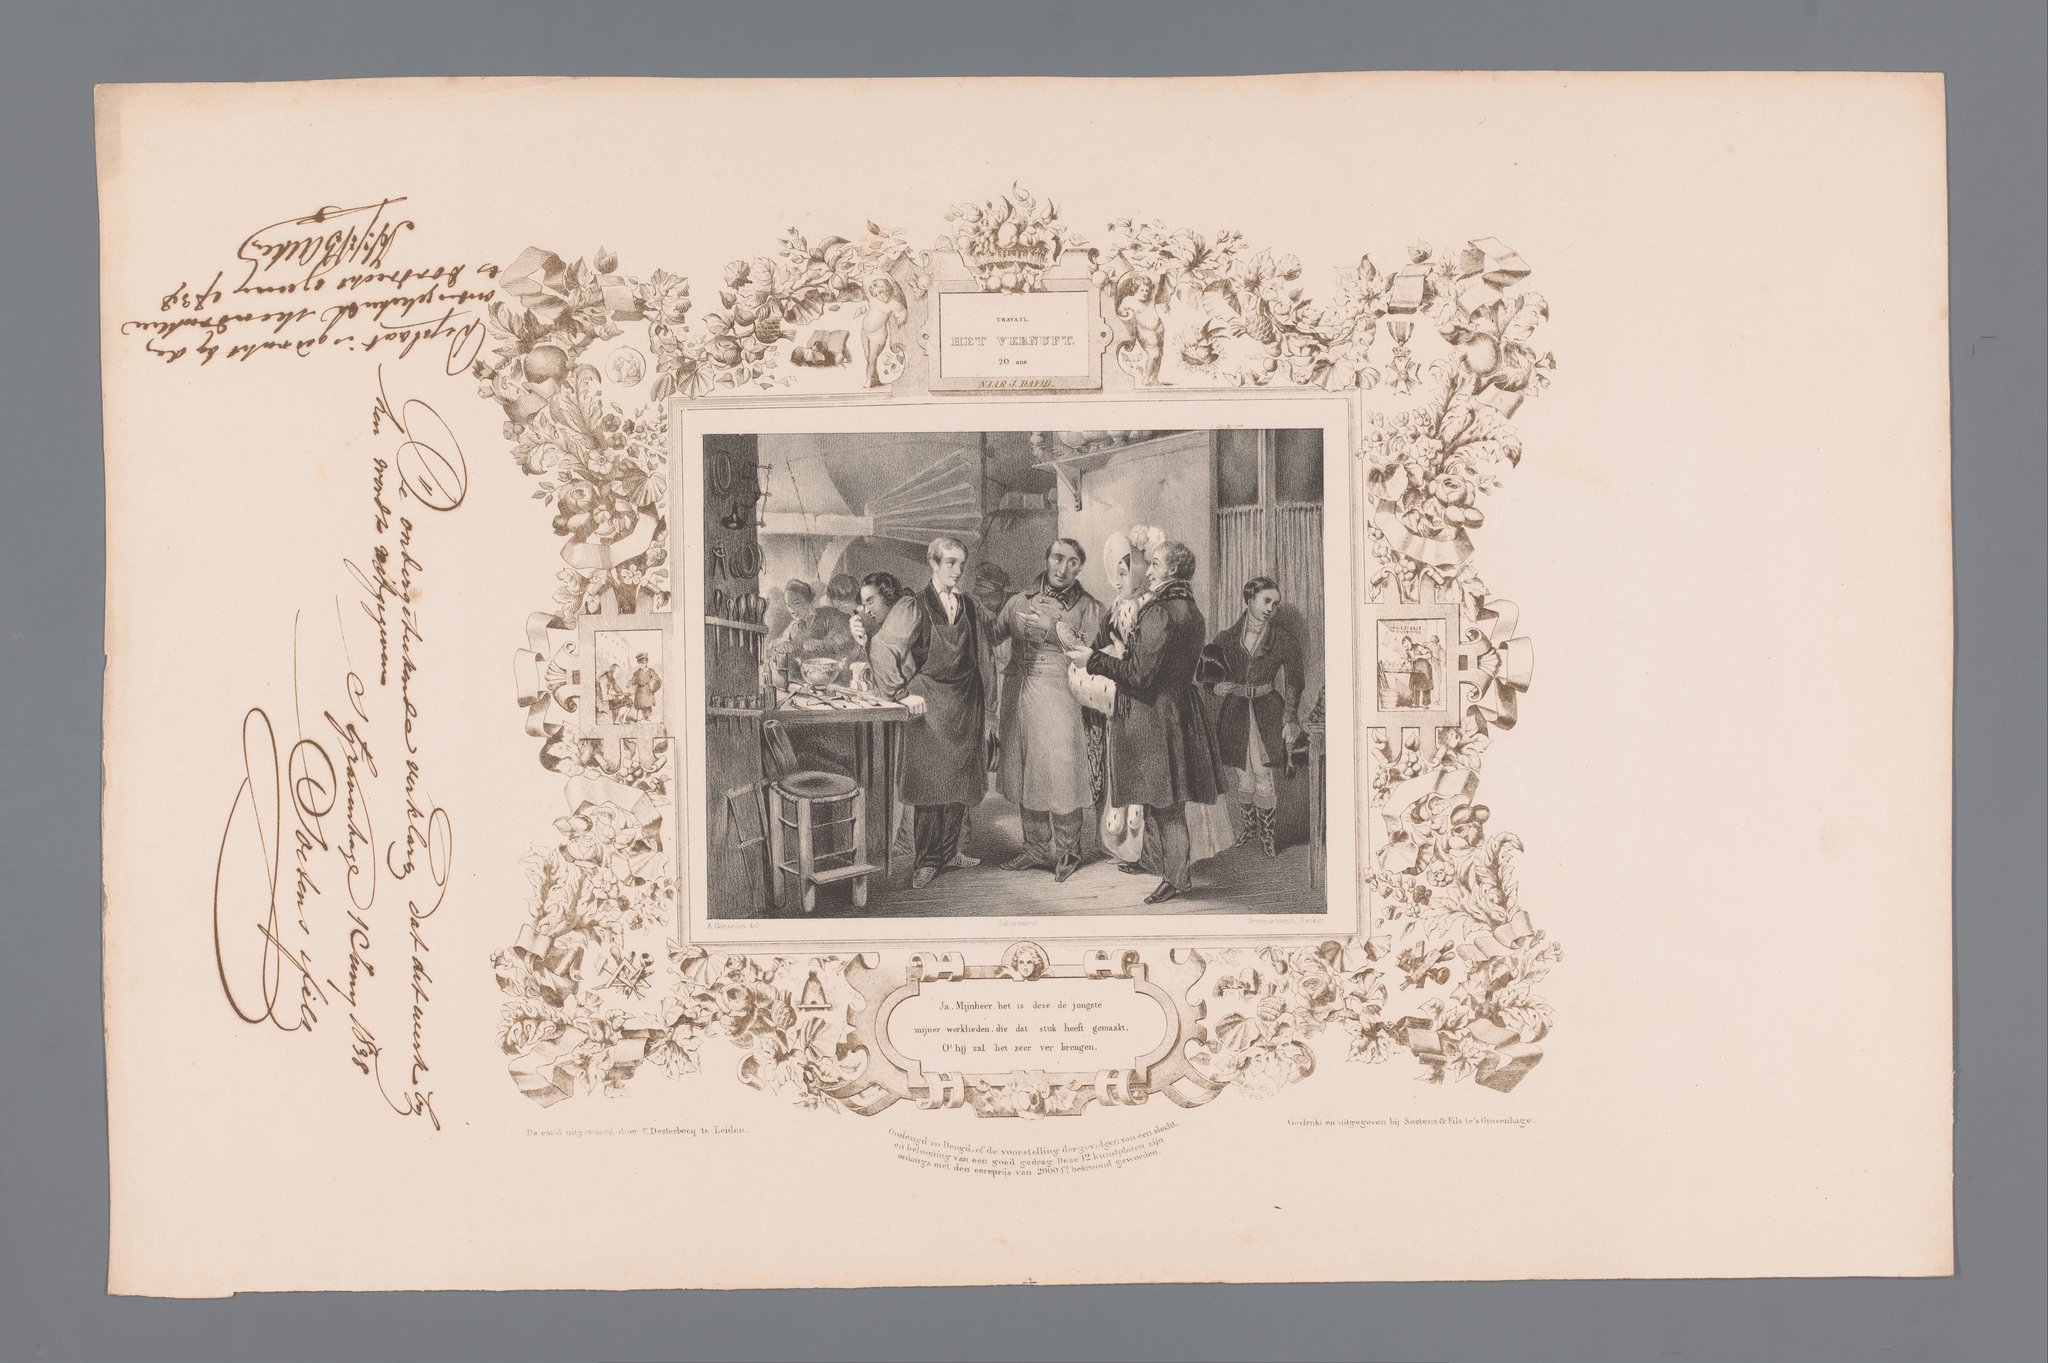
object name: print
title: Het vernuft 20 ans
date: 1837-1840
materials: paper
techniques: lithograph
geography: the hague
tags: handicrafts, craftsman at work, factory-interior, machine shop, rewarding goodness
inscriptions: : ‘De plaat is gedrukt bij den / ondergetekende steendrukkers / te Dordrecht 1 juny 1838 / H. J. Backer’, : ‘Gedeponeerd’, : ‘De ondergeteekende verklaren dat dit werk bij / hen wordt uitgegeven / S Gravenhage 1 juny 1838 / Soetens Fils’ Lugt 2228, collector's mark: Lugt 2228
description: In de rand symbolen die verwijzen naar deugd zoals het geven van een aalmoes, noeste arbeid en een ridderorde. Maakt deel uit van een omslag met zes prenten.